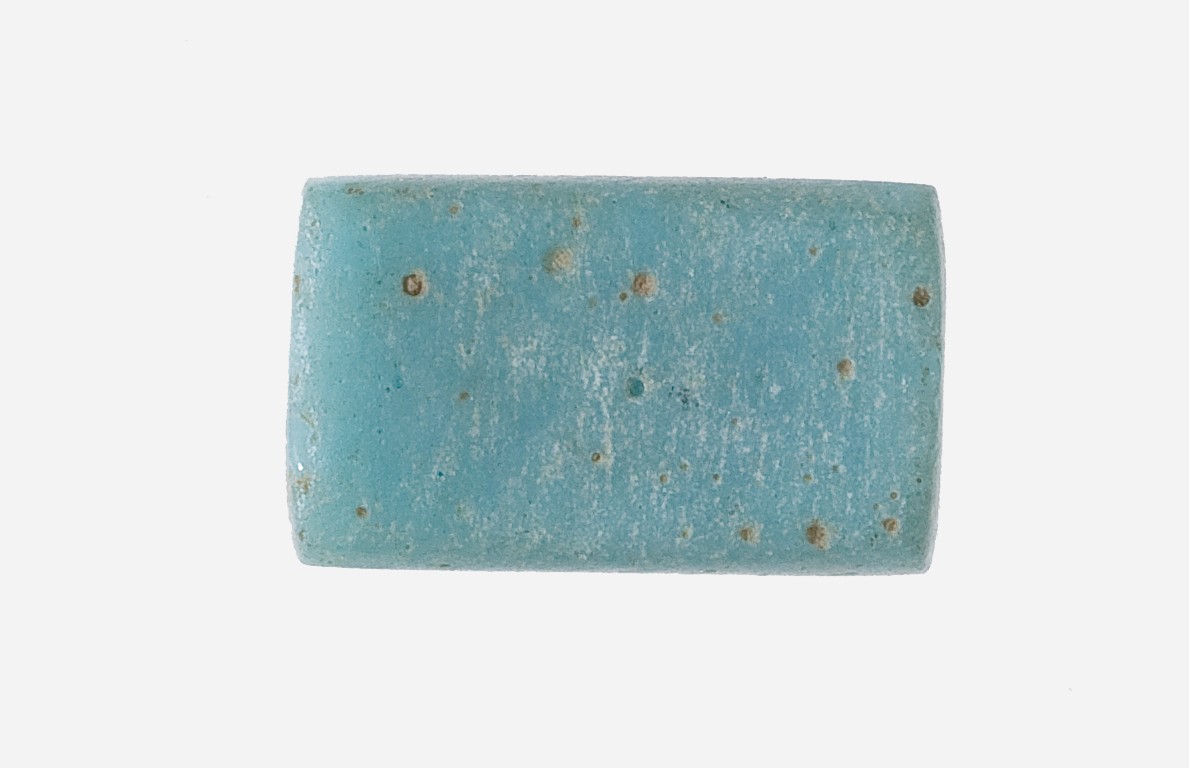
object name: foundation deposit plaque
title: Plaque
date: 1390-1352 BCE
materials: glass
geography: egypt